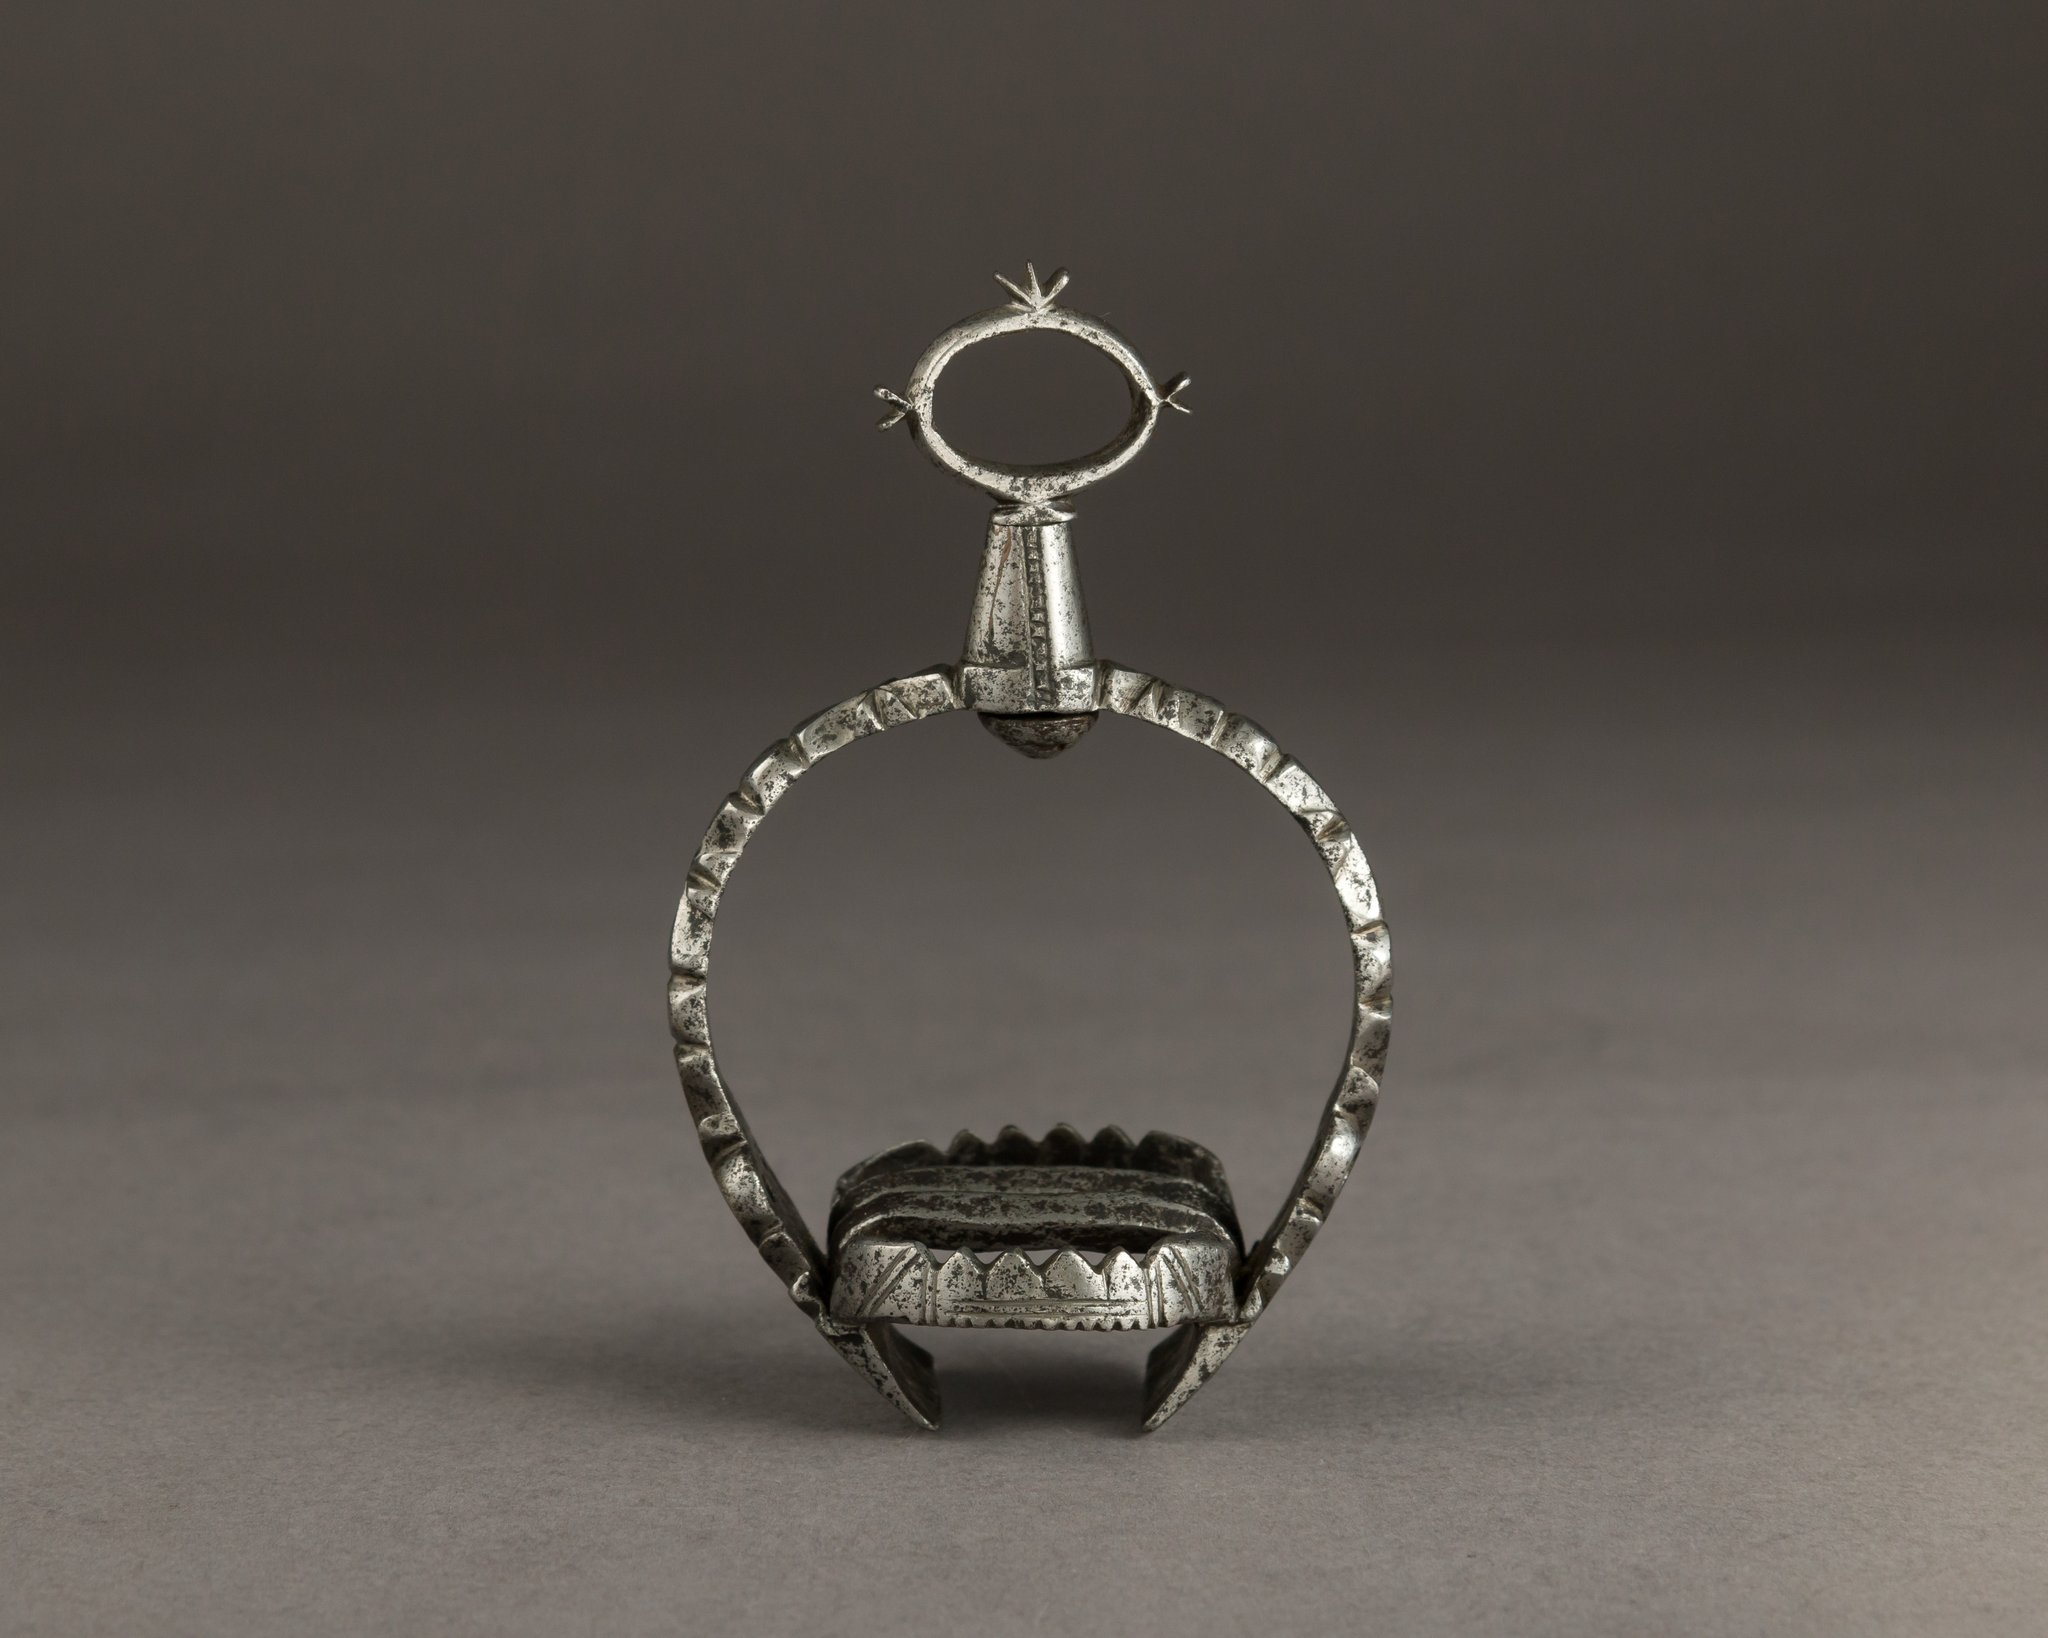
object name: stirrup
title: Stirrup for a Child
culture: german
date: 1651-1700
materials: metal alloy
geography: germany